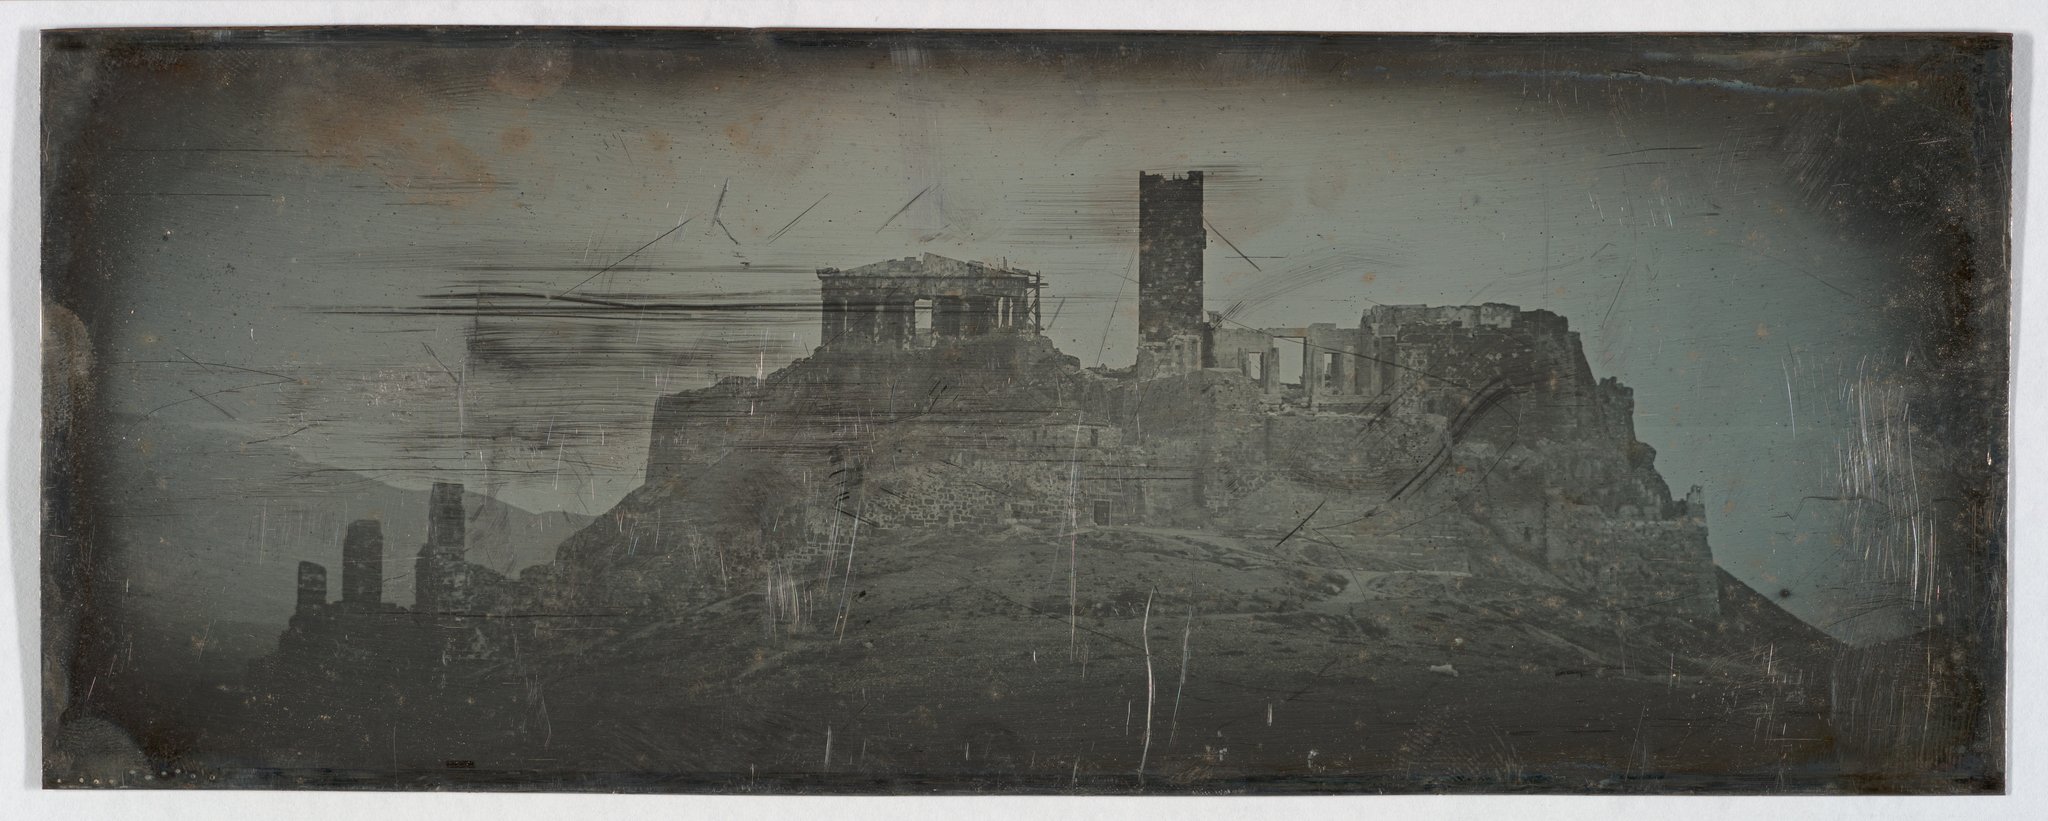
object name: photograph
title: Western Approach to the Acropolis, Athens (49. Athènes. 1842. Acropole. Côté O.)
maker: joseph-philibert girault de prangey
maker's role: artist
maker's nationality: french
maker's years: 1804-1892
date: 1842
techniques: daguerreotype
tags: architecture,ruins